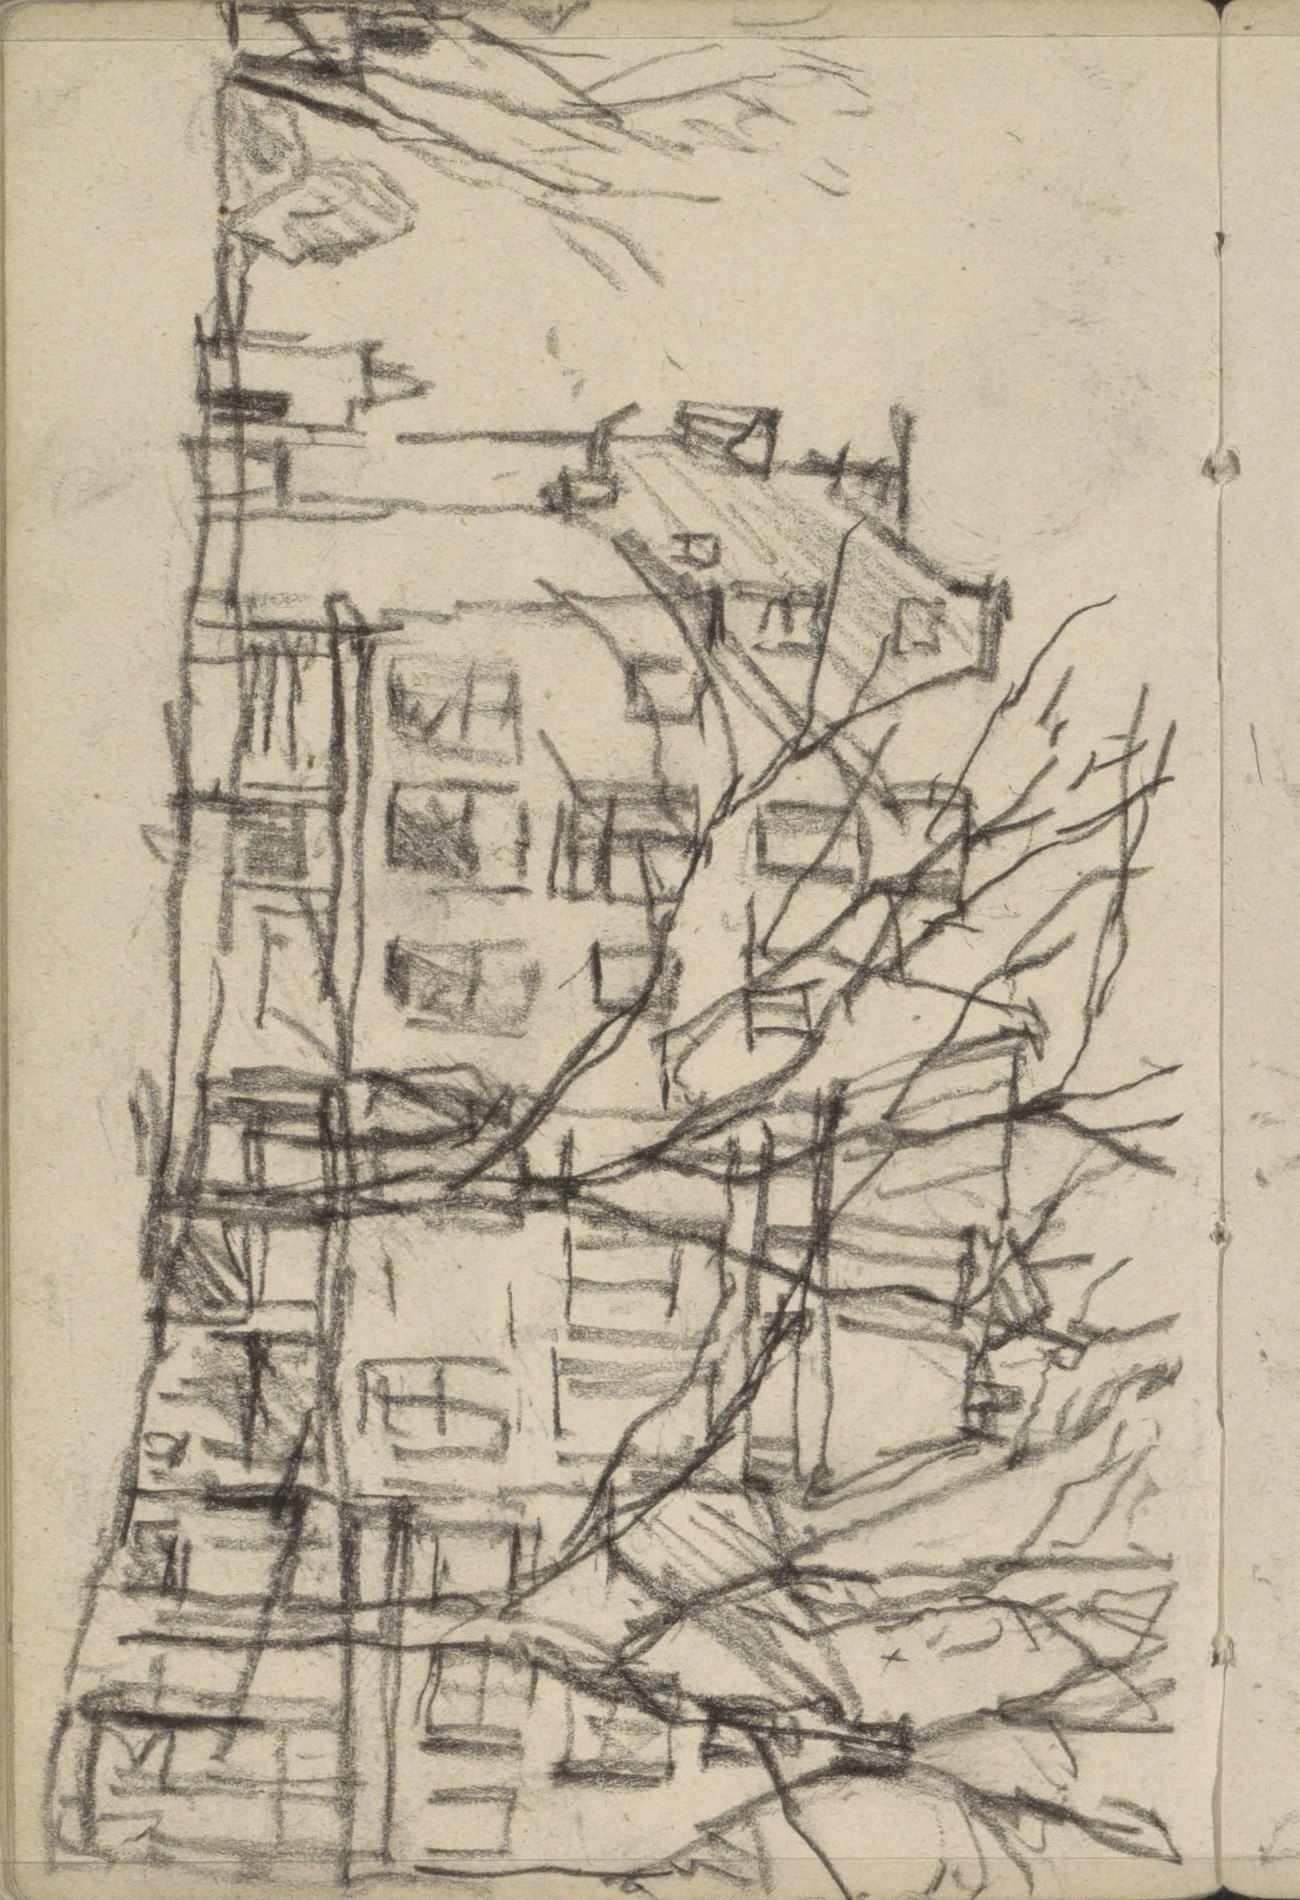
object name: sketchbook leaf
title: Gezicht in Amsterdam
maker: george hendrik breitner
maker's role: draughtsman, painter, print maker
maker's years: 1857-1923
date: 1914-1923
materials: chalk, paper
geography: amsterdam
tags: urban housing, city-view, and landscape with man-made constructions, amsterdam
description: Gezicht in Amsterdam. Pagina 79 uit een schetsboek met 43 bladen vervaardigd te Amsterdam.